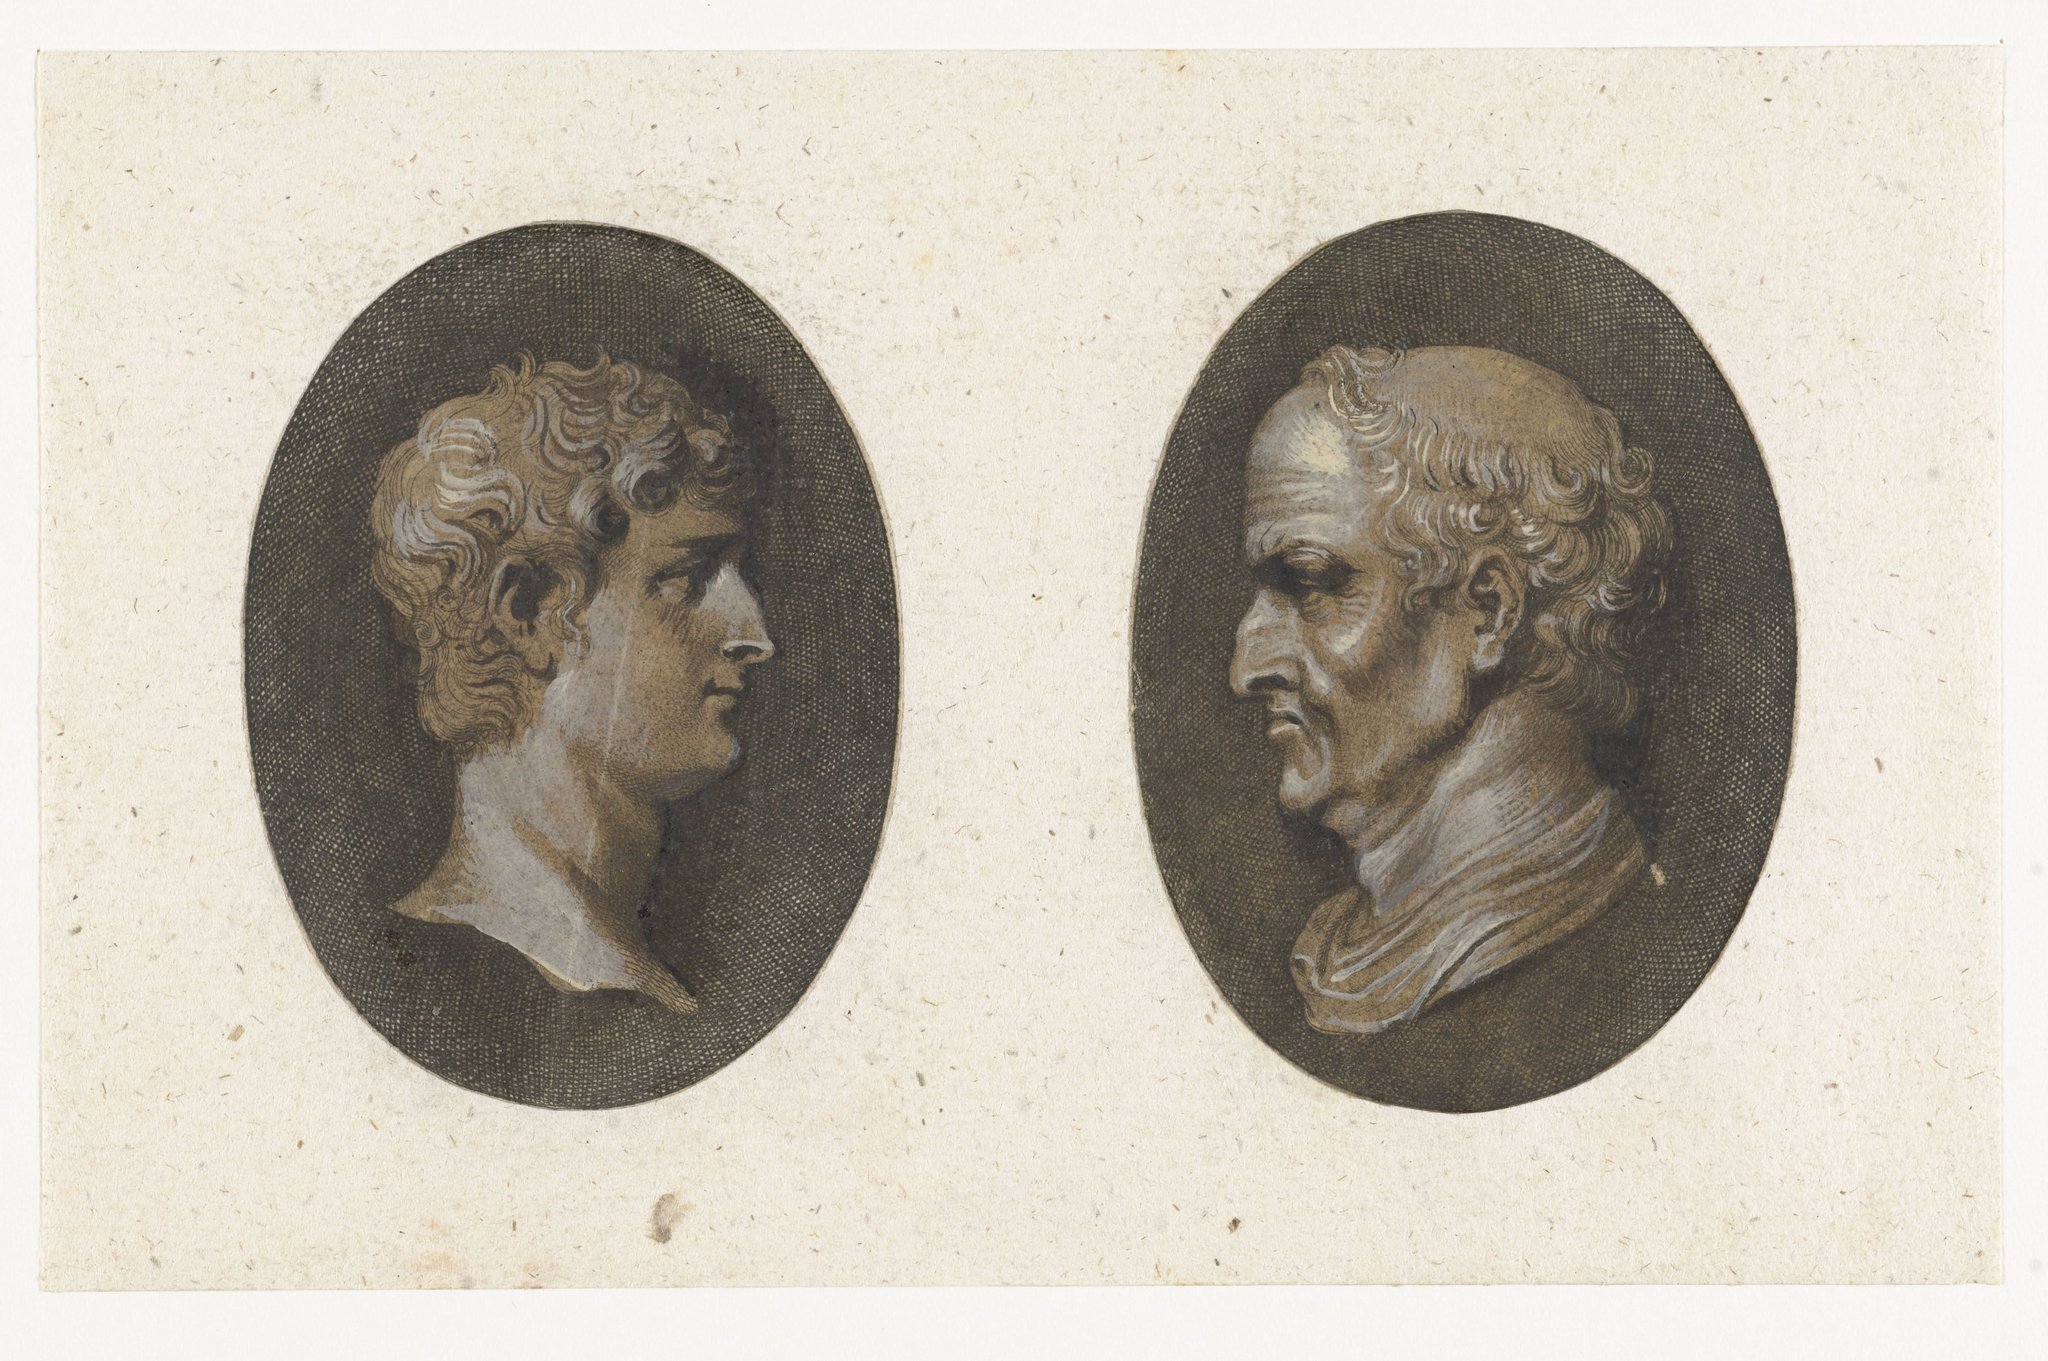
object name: drawing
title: Antieke camee met portretkop, in profiel naar links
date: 1613-1640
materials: oil, paper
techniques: brush, printmaking, engraving, pen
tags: head (human), old man, precious and semiprecious stones